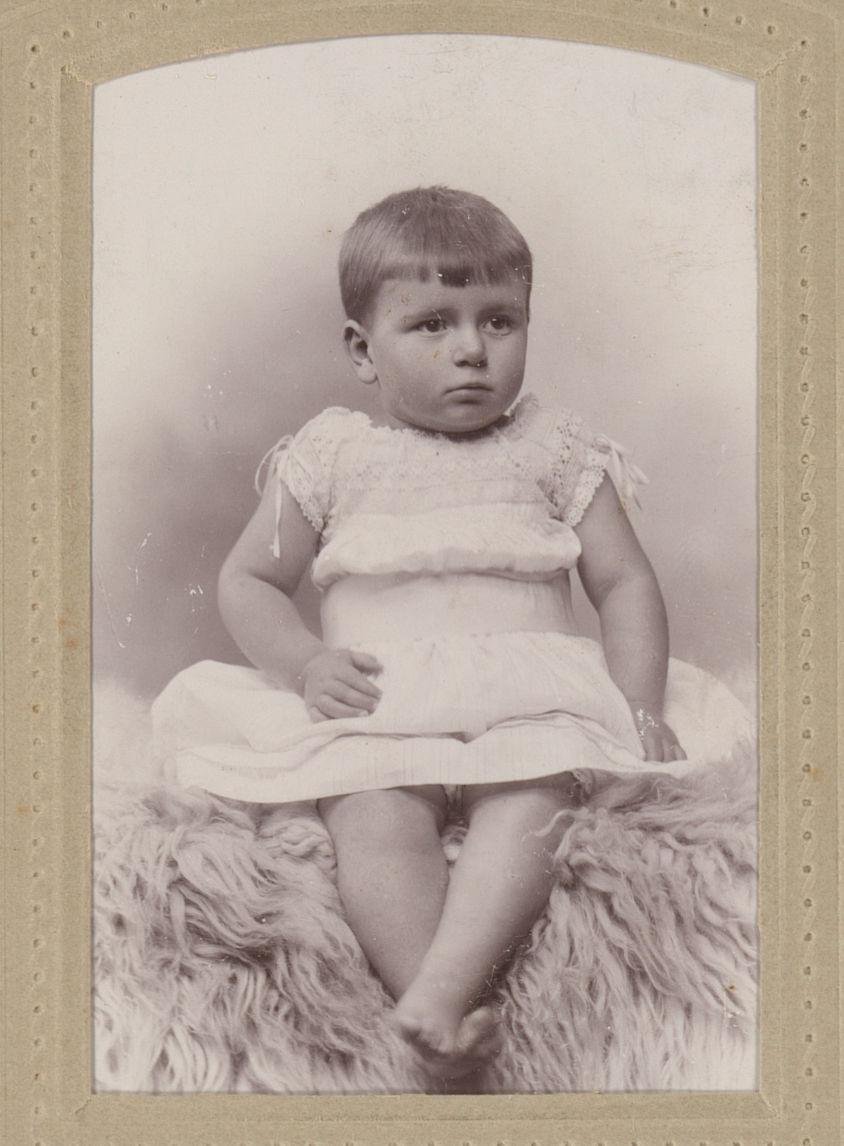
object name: photograph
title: Studioportret van Jan Kessler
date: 1893-1895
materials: paper, photographic support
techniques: collodion silver print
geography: the hague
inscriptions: retailer's mark: ‘Kameke peintre et phot: de la Courb La Haye Javastraat 20’